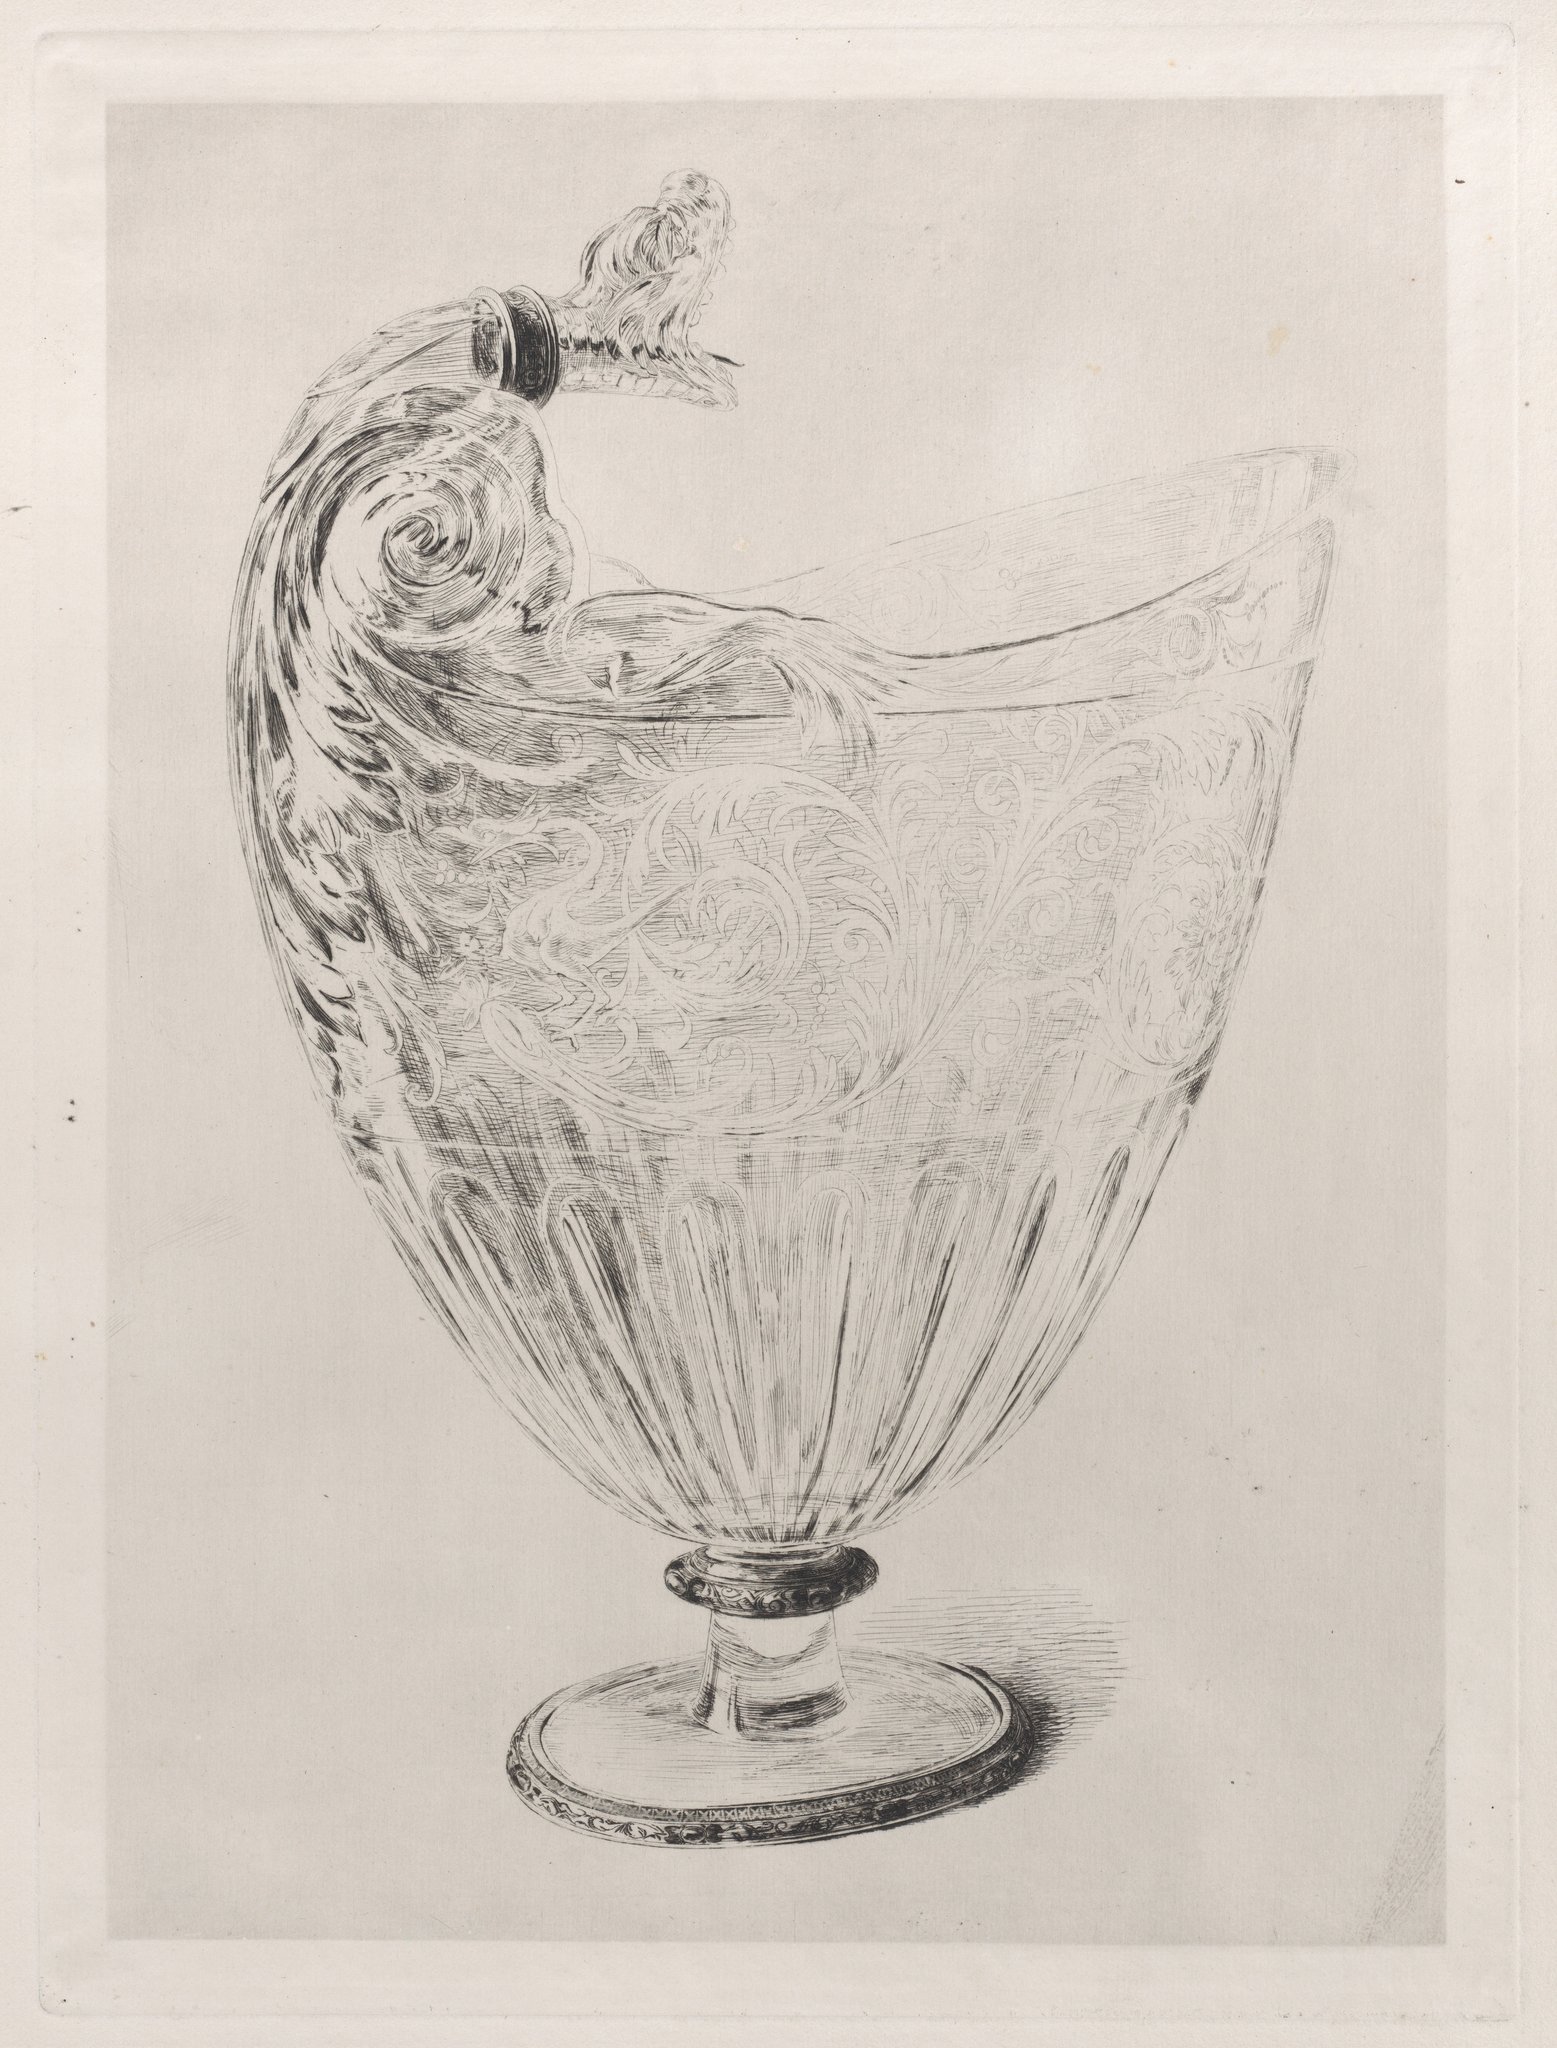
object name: print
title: Crystal Bezel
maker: jules-ferdinand jacquemart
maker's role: artist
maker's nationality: french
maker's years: 1837-1880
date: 1868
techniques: etching